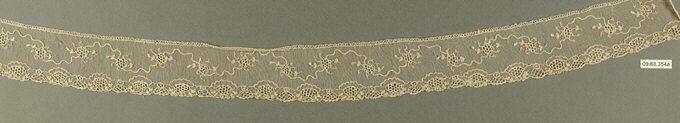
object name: edging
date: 1767-1800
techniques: lace